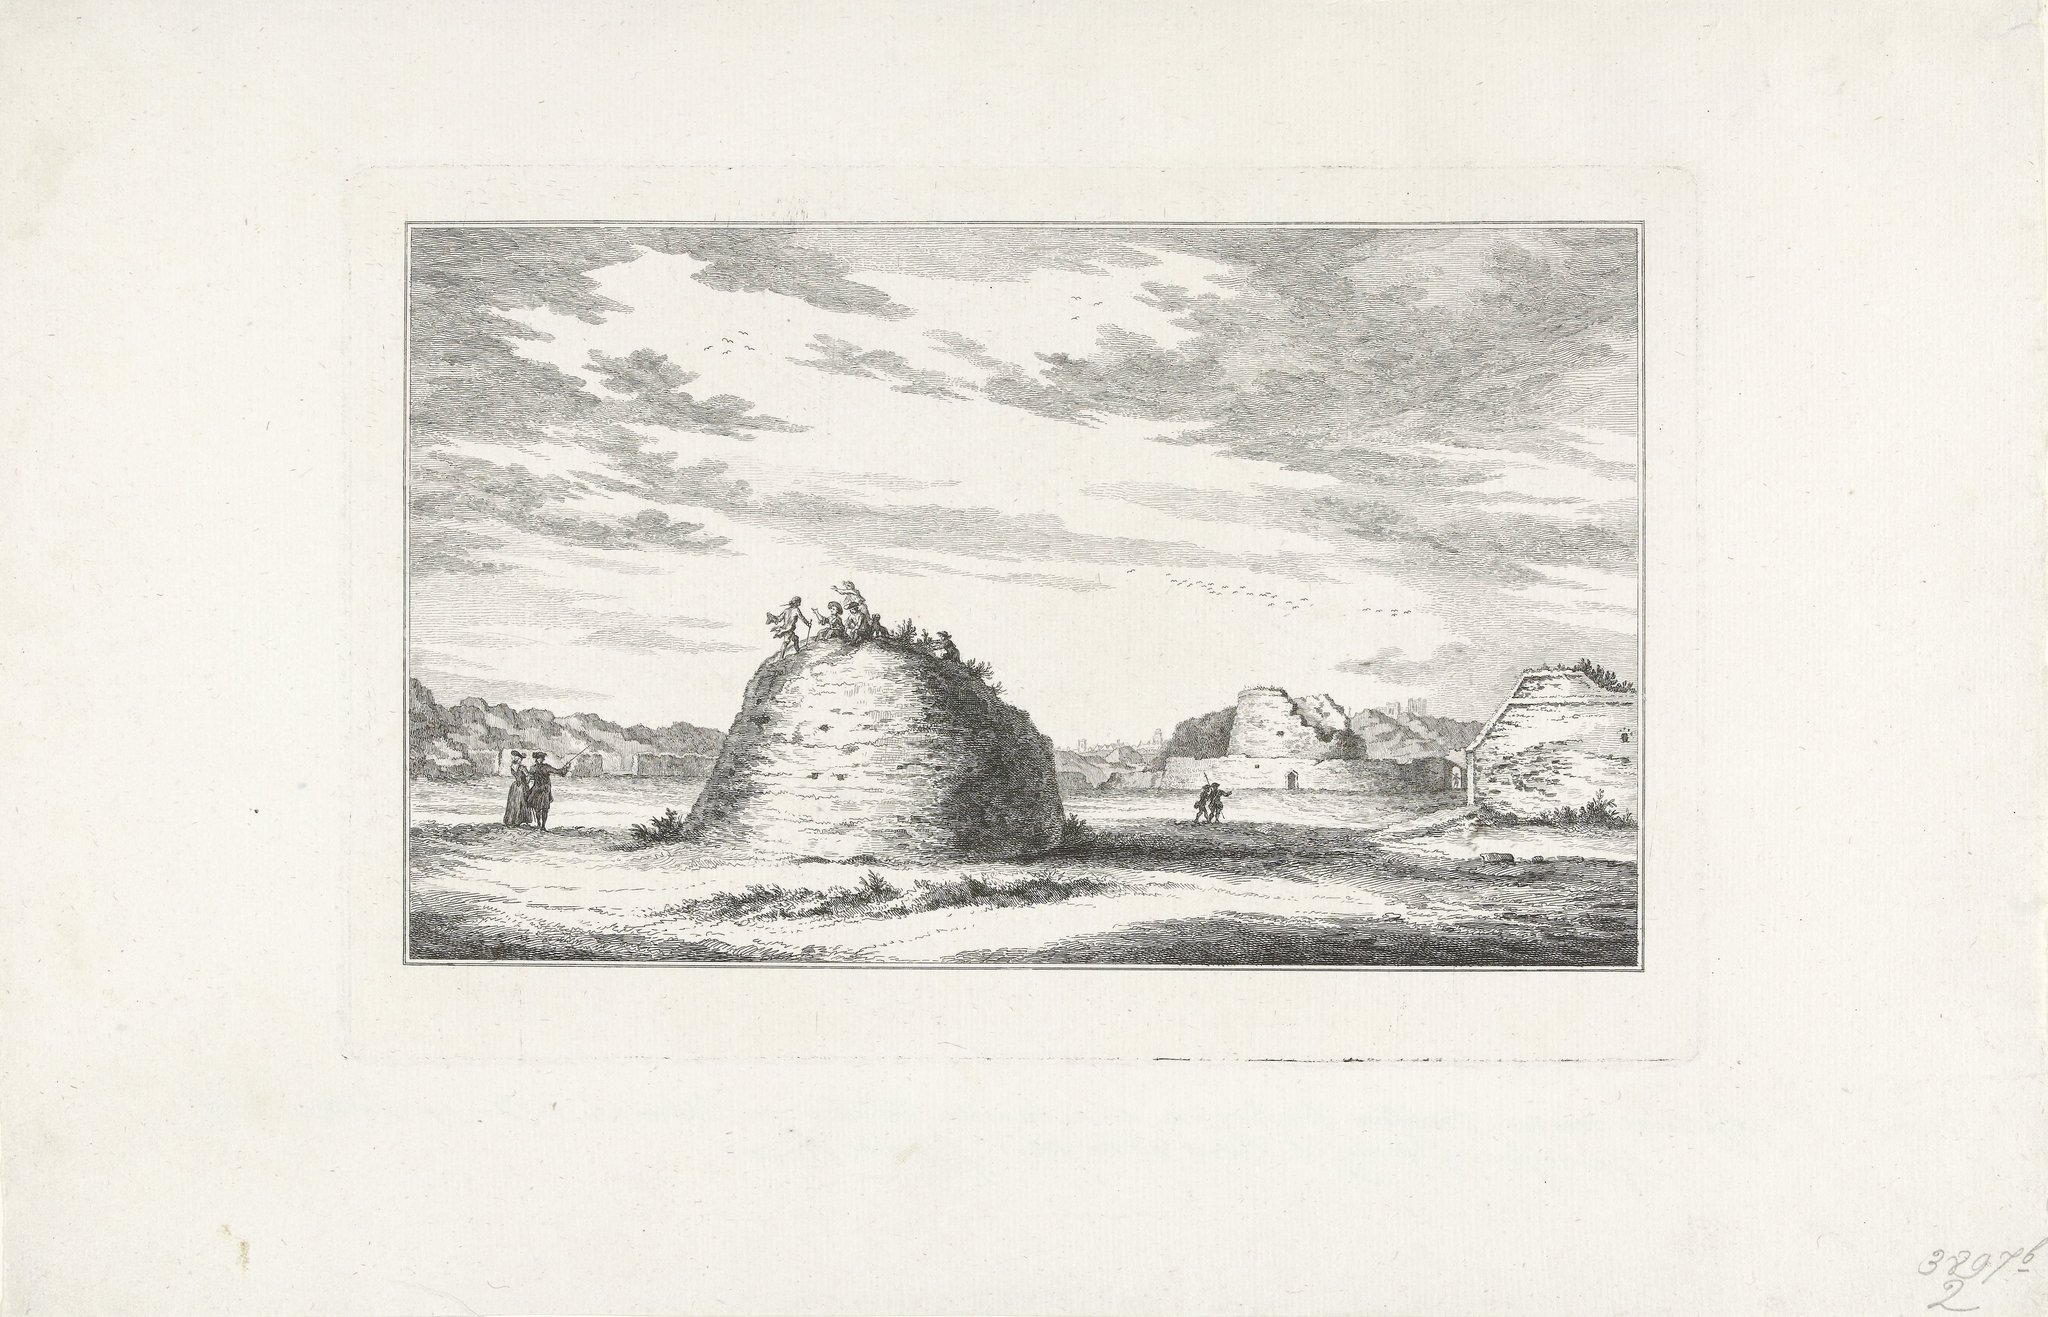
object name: print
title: Ruïnes van de orillon Coehoorn en de lunetten Zeeland en Utrecht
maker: simon fokke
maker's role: draughtsman, print maker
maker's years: 1712-1784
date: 1772-1780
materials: paper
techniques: etching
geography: northern netherlands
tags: fortress, landscape with ruins, bergen op zoom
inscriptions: collector's mark: Lugt 2228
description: Prent ook gebruikt in: Beschryving der stad Bergen op den Zoom (…). 1e druk. Amsterdam: Arend Fokke Simonsz., 1780. Muller geeft aan dat de prenten door Simon Fokke in 1772 naar de tekeningen van Pronk uit 1748 zijn vervaardigd. In de Collecties Thuis in Brabant (collecties in Brabantse musea en archieven) is een ontwerptekening (met inv.nr.: BC-Tha oai:tha.uvt.nl:709121) voor deze prent in de serie bewaard met de annotatie: Hoogstraat. na t Leven geschest (sic) door C.Pronk 1748. opgetekent door S. Fokke 1772.